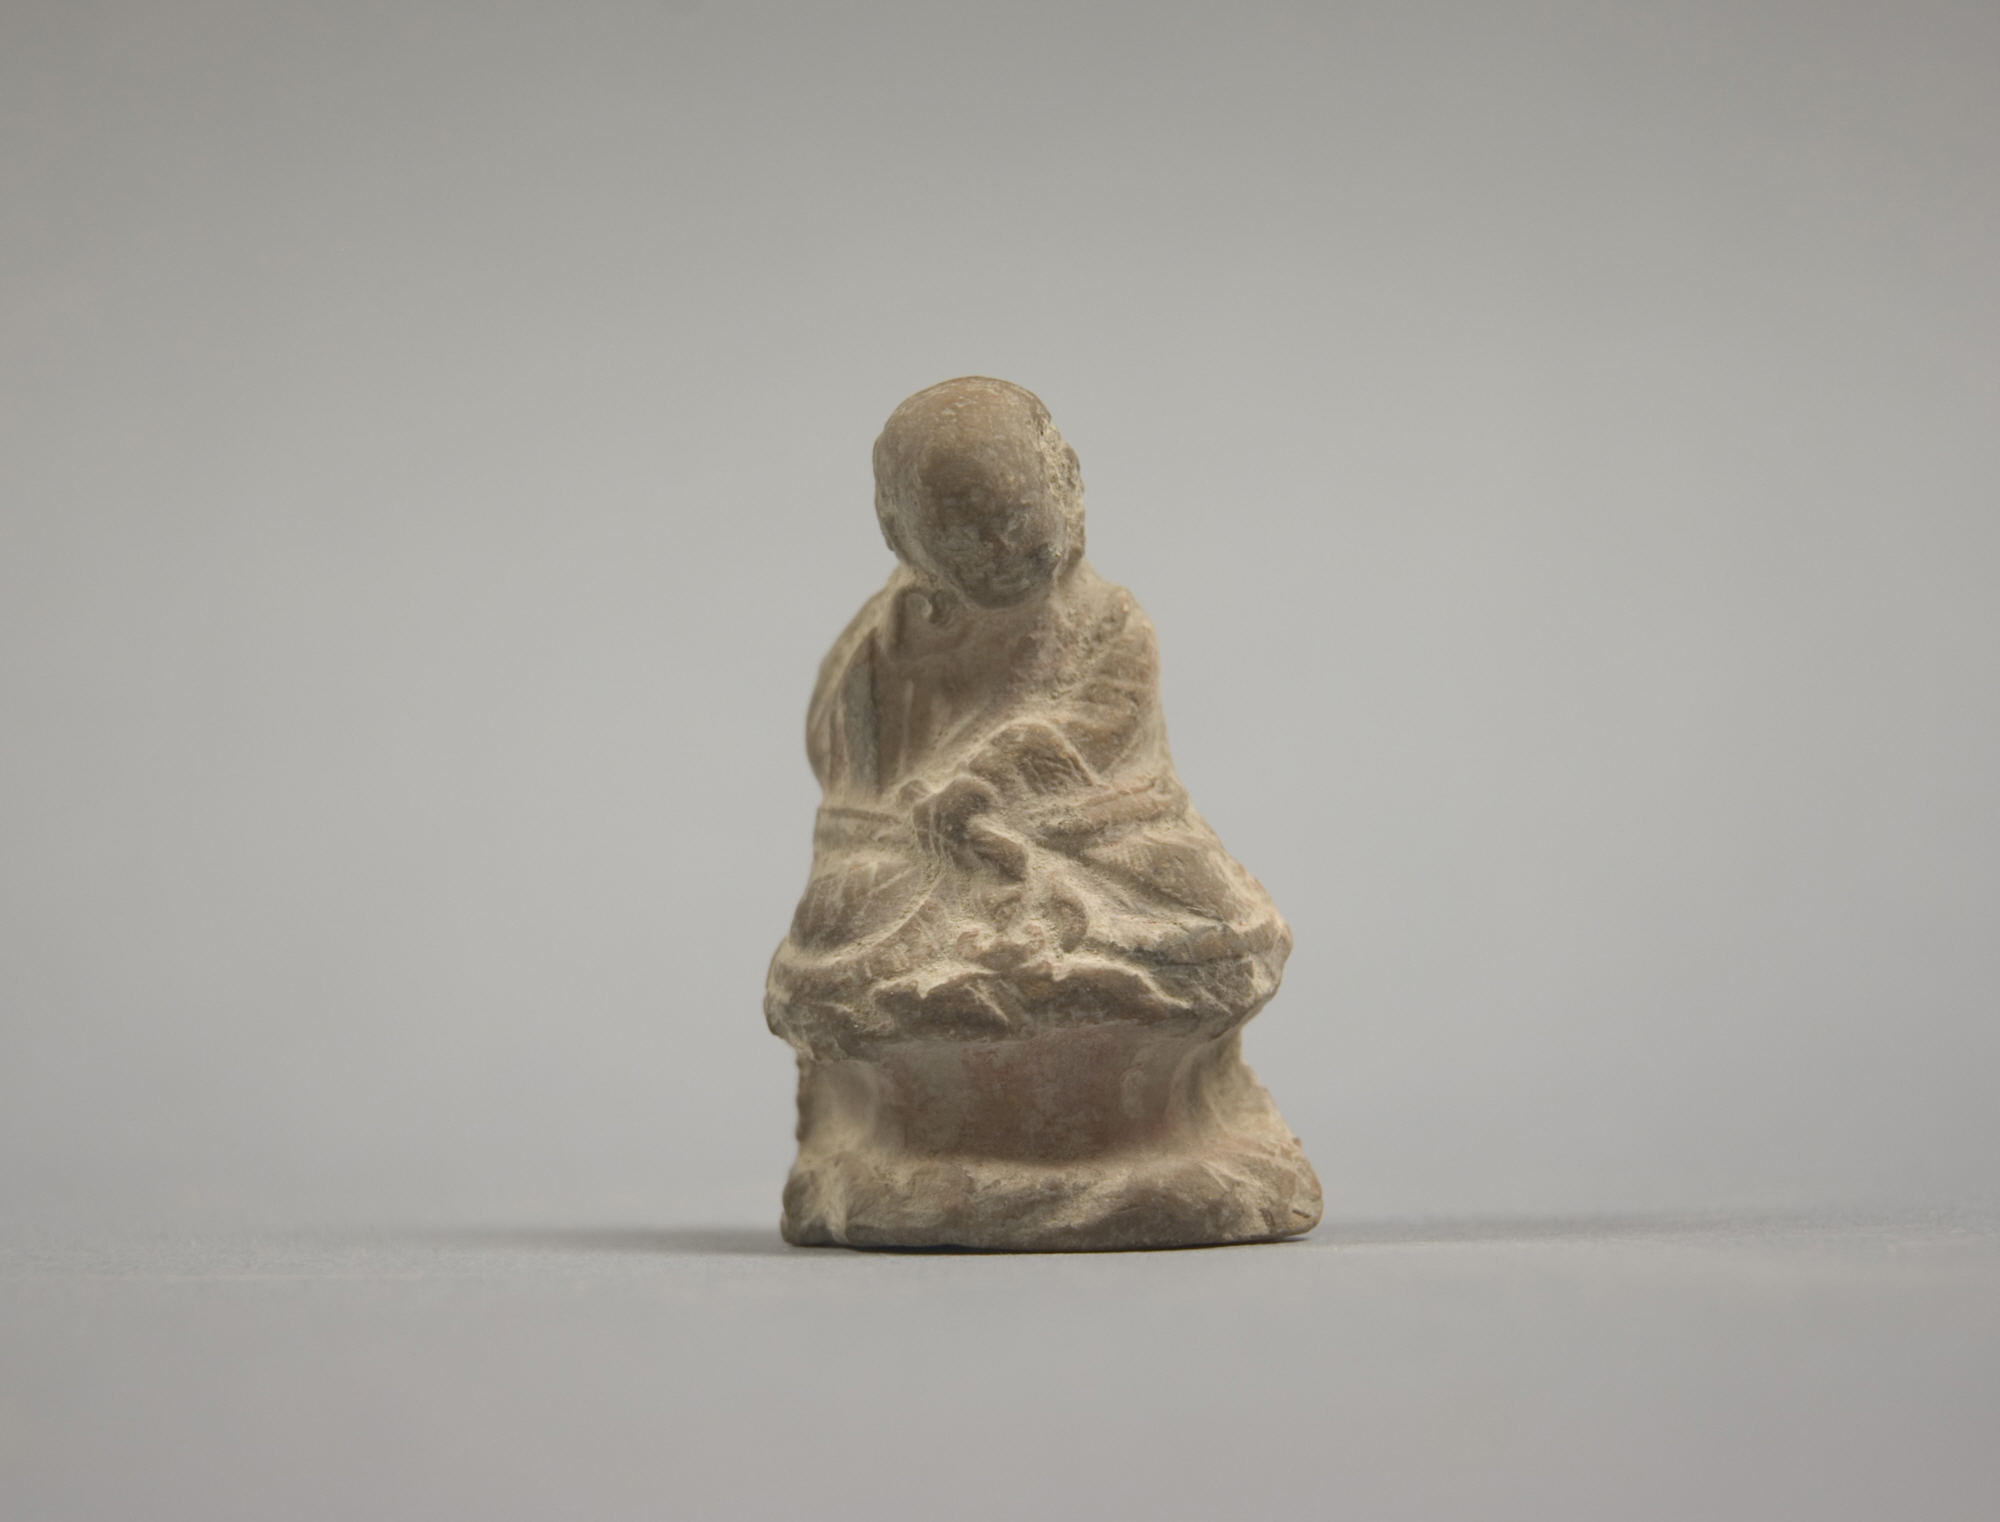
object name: figure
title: Figure of Luohan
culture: chinese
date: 960-1279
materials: pottery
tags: human figures